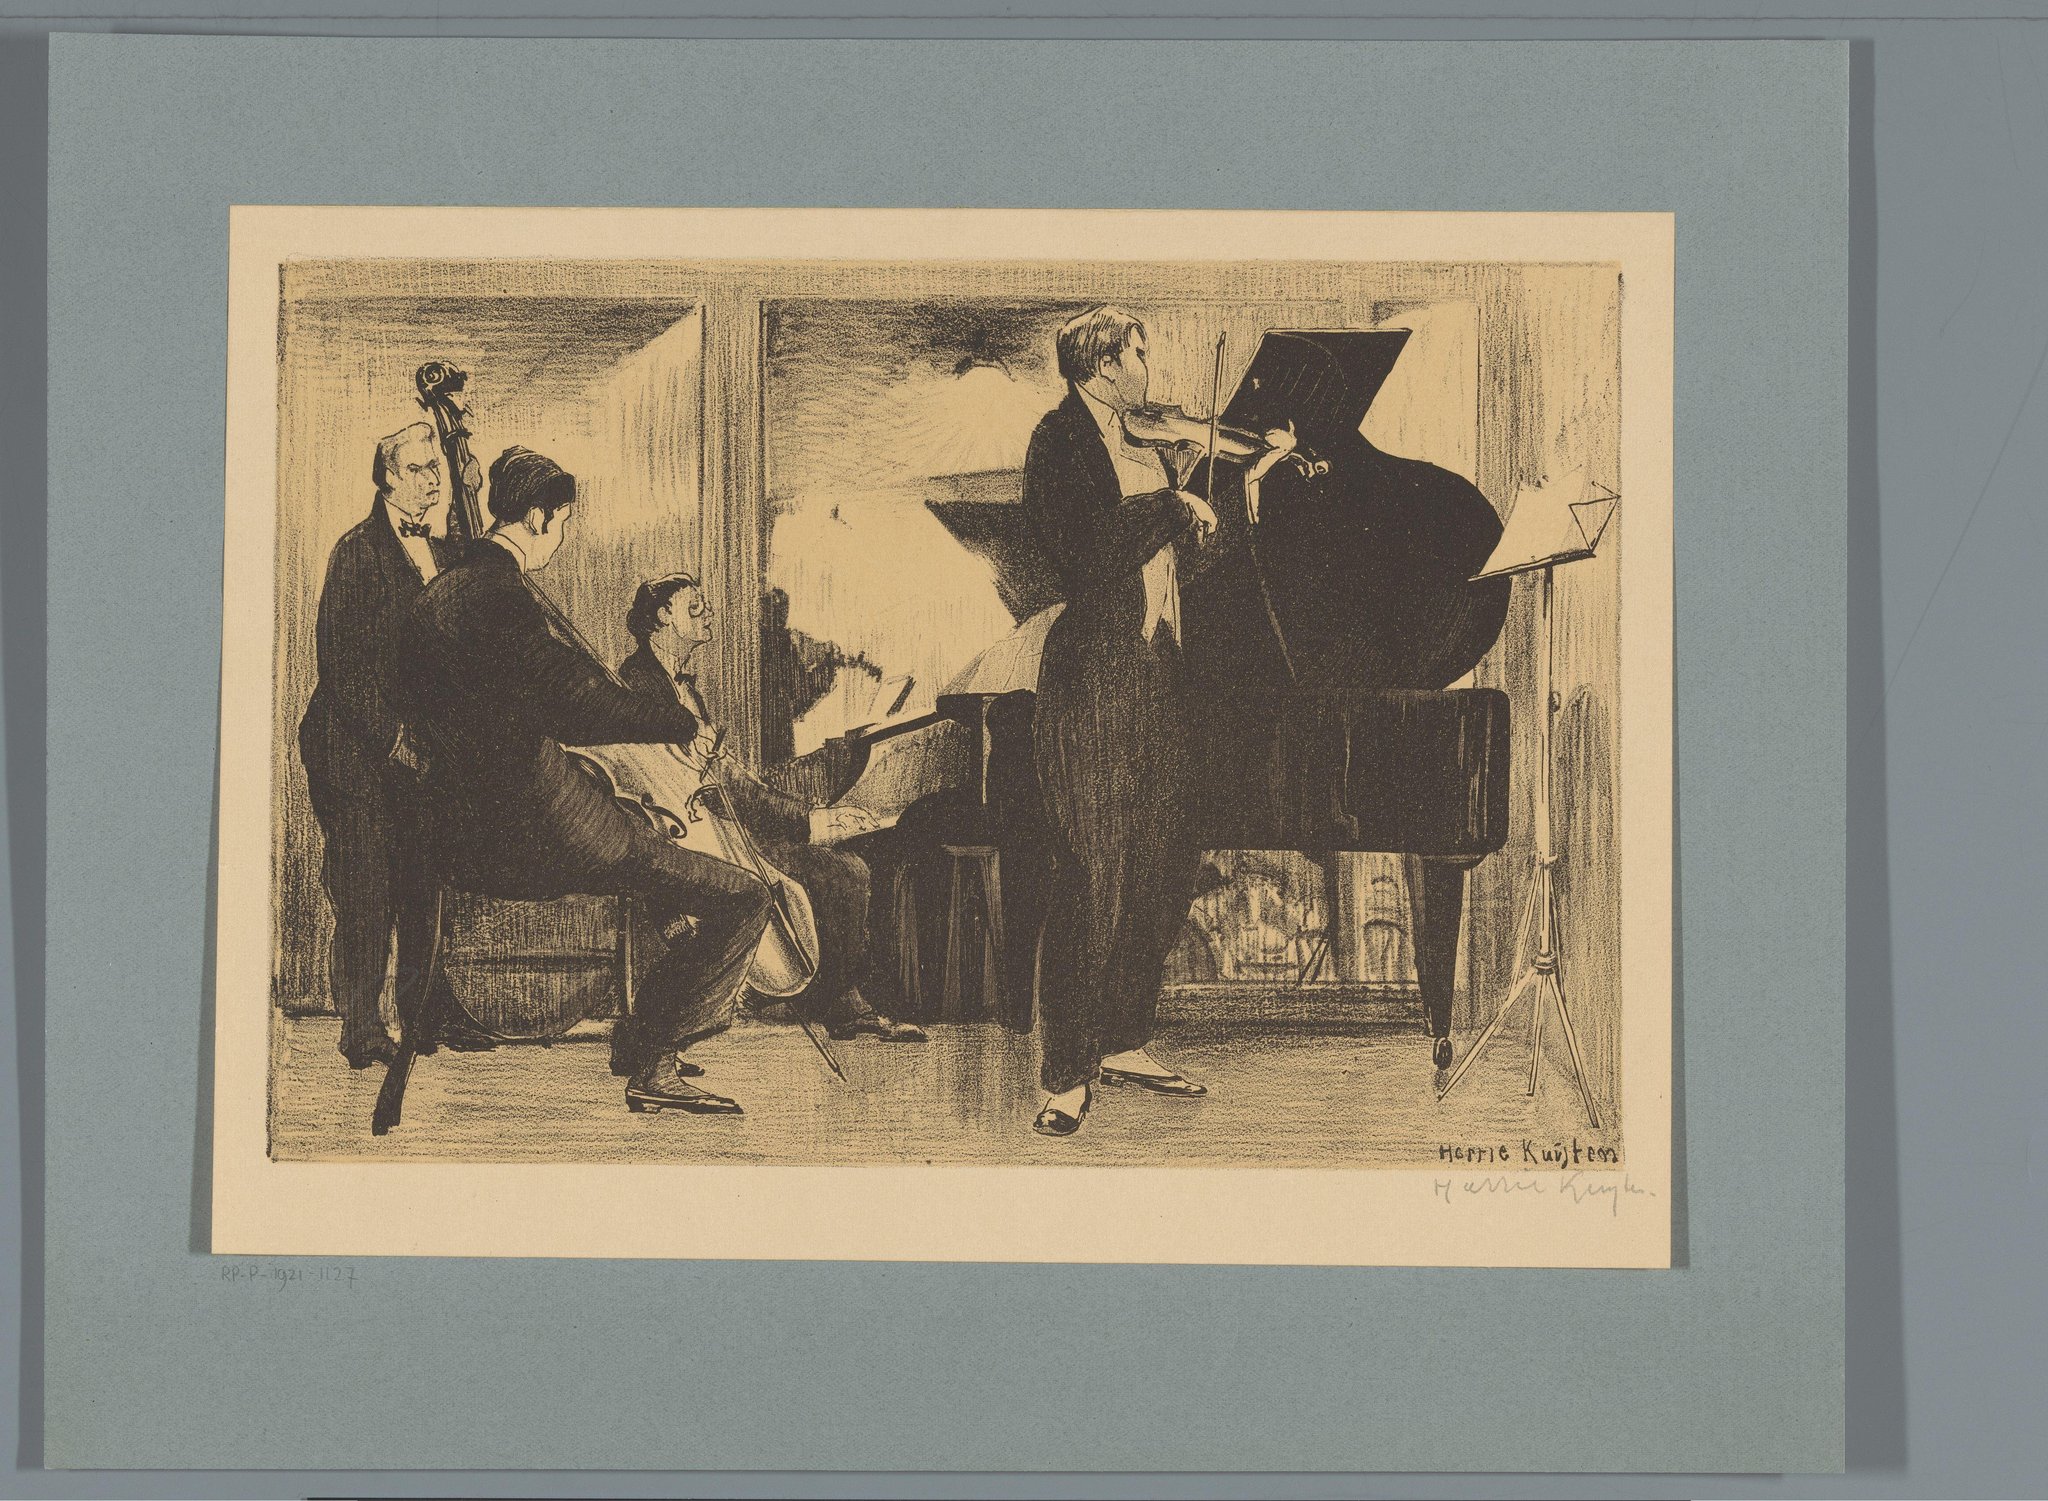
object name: print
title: Pianokwartet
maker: harrie kuyten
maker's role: print maker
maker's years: 1883-1952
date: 1893-1921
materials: paper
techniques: tone lithography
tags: small group of musicians, chamber orchestra, jazz band, grand piano, violin, fiddle, viola, violoncello; double bass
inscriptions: collector's mark: Lugt 2233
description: Een pianokwartet met een contrabas, cello en viool. Deze prent maakt deel uit van een omslag met zes prenten.